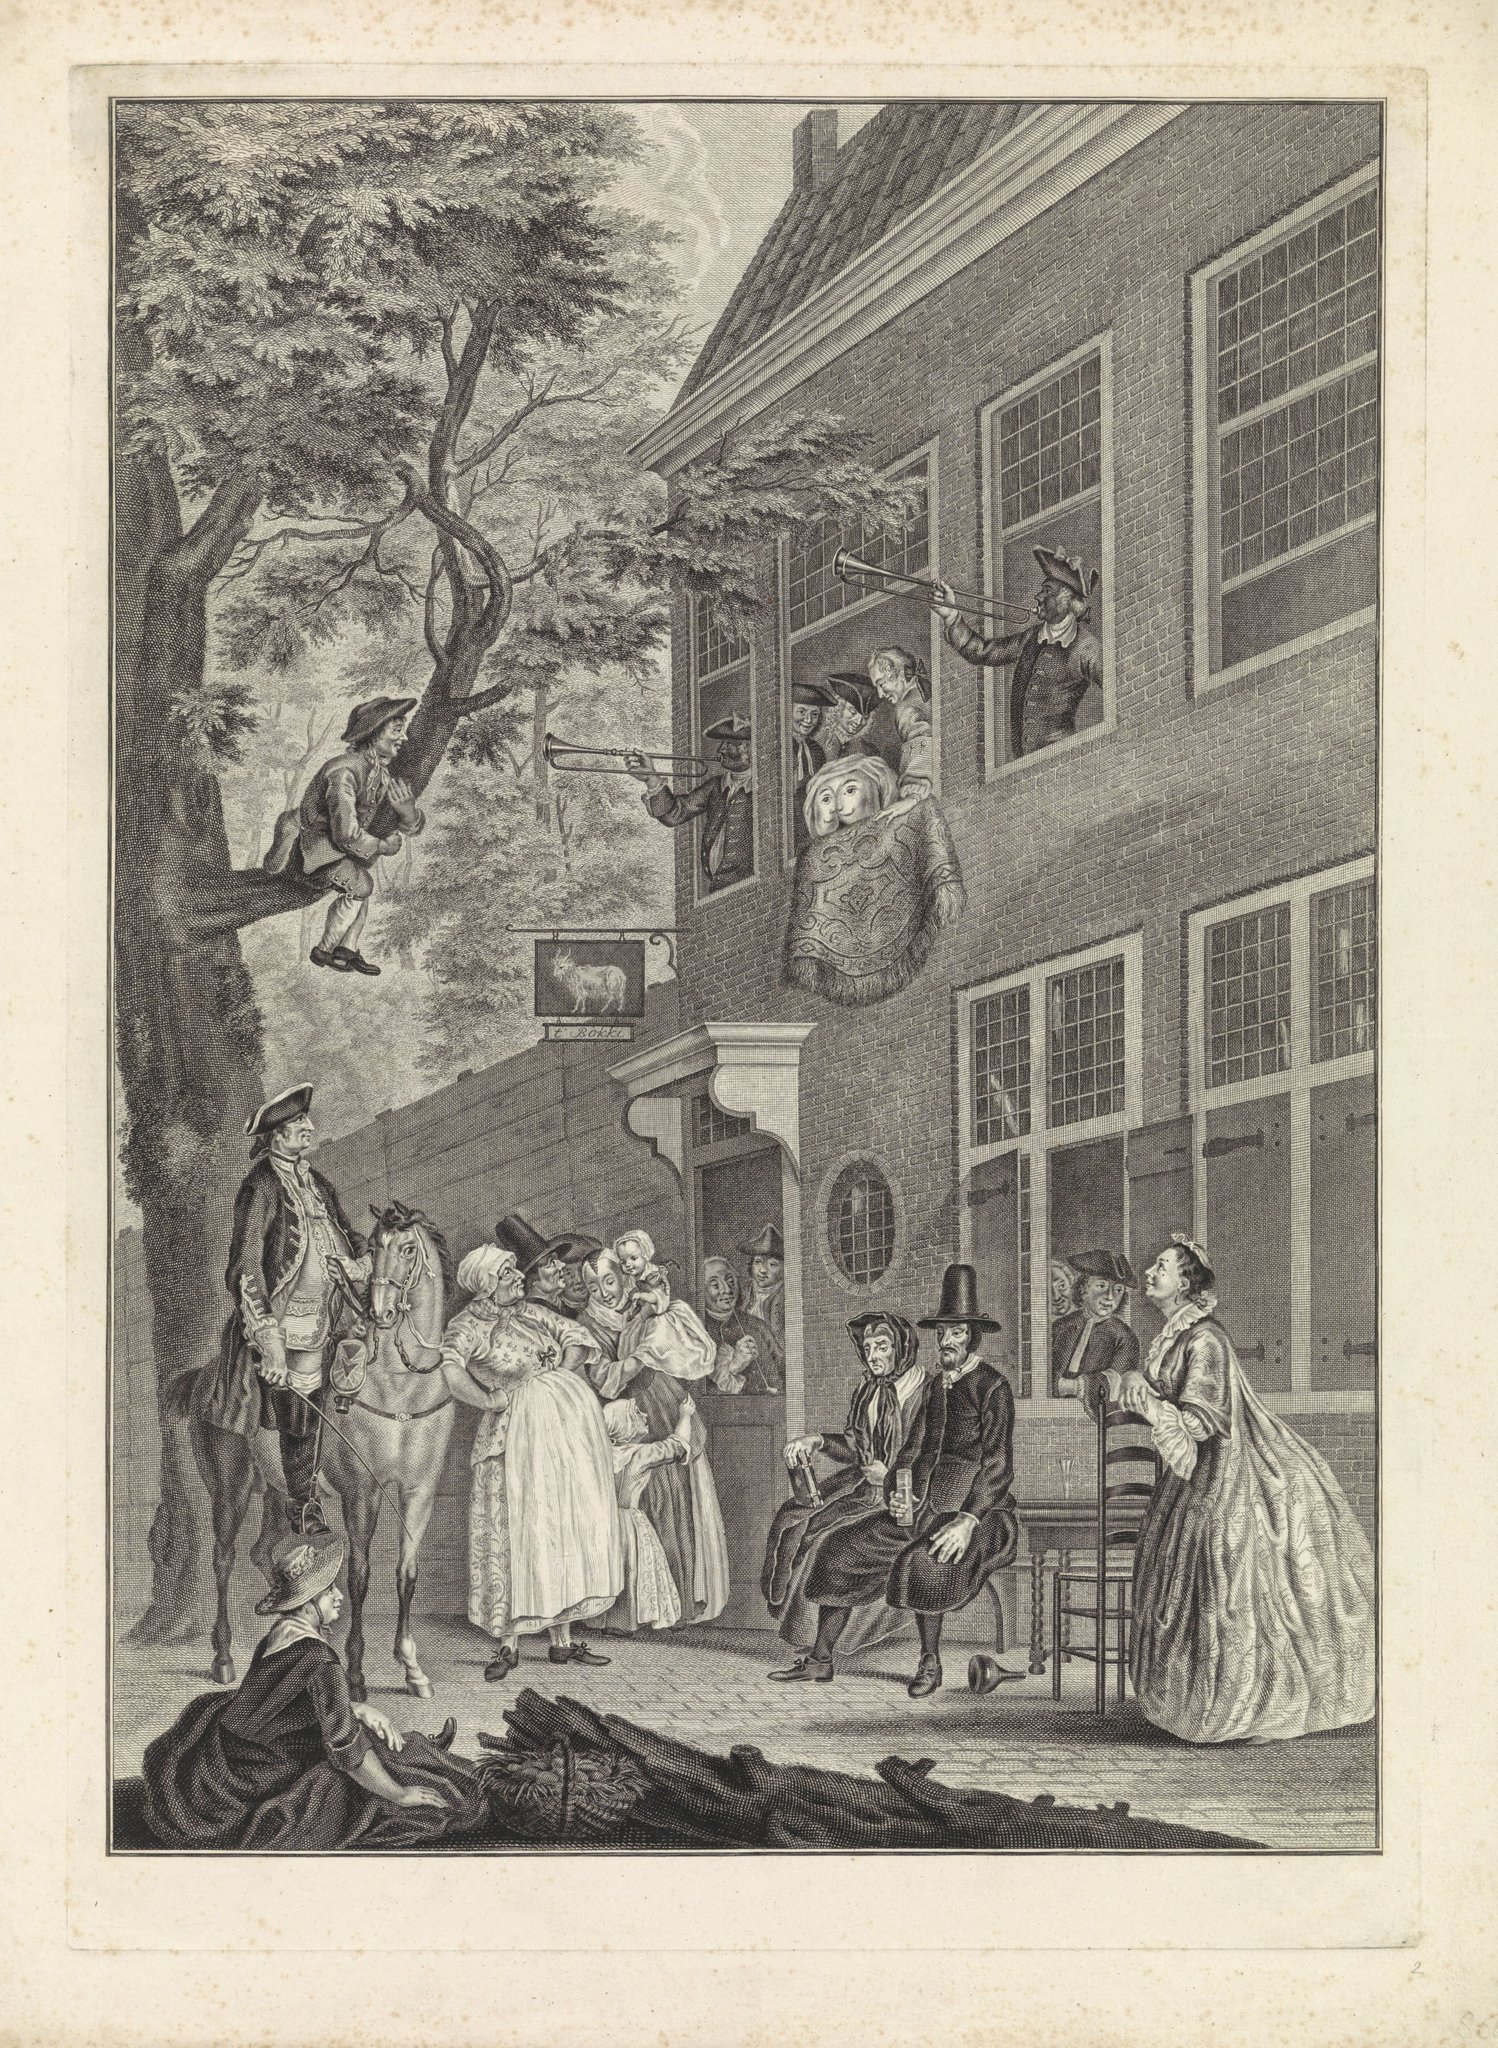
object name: print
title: De misleyden: de ambassadeur der Labberlotten vertoont zich voor het venster van de herberg 't Bokki in de Haarlemmerhout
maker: abraham delfos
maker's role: draughtsman, painter, print maker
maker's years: 1731-1820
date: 1750-1820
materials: paper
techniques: engraving, etching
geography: leiden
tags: mocking, insulting; teasing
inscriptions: collector's mark: Lugt 240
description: De misleyden: de ambassadeur der Labberlotten vertoont zich voor het venster van de herberg 't Bokki in de Haarlemmerhout (een grap bedreven door Jacob Campo Weyerman en consorten). Een groep mensen kijkt naar het als een gezicht beschilderde achterwerk van een man, uit het venster van de herberg gestoken. Aan weerszijden twee trompetters met zwart geverfde gezichten. Voor de herberg zitten een in zwart geklede man en vrouw, bijbels in de hand.